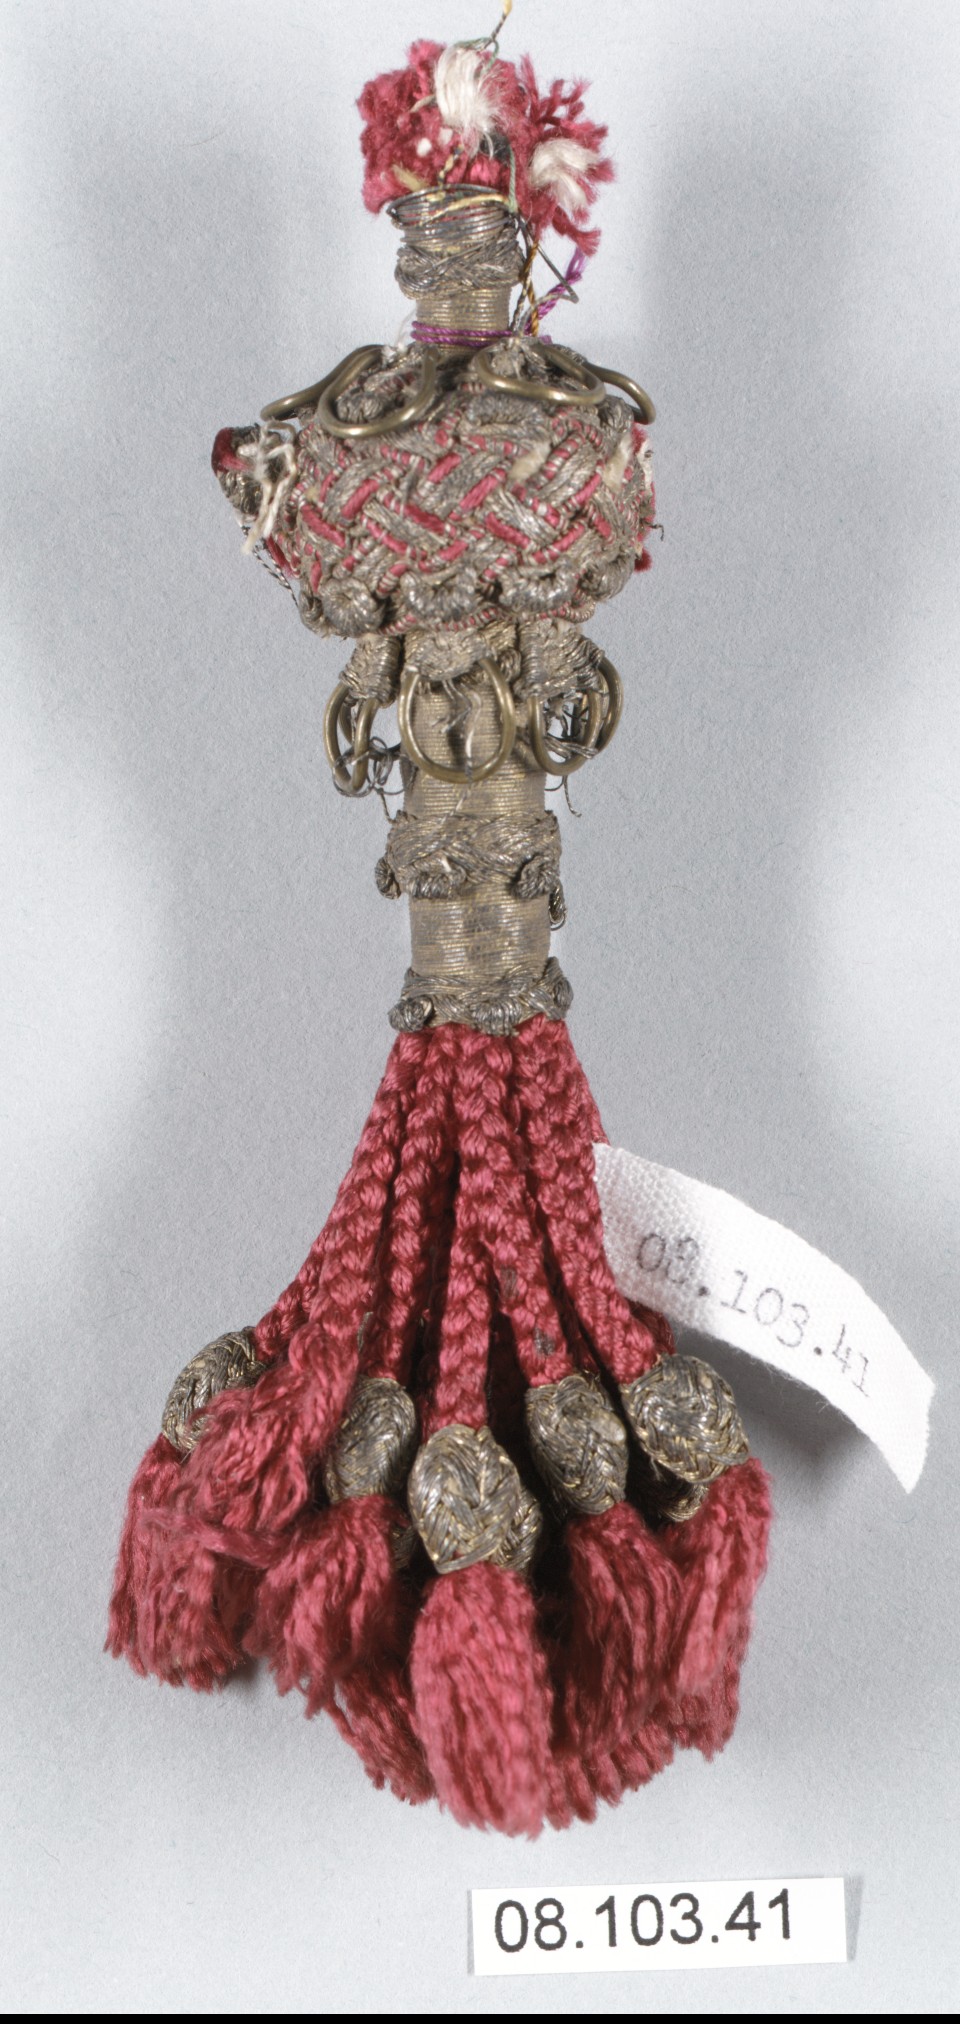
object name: tassel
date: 1601-1700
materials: metal thread, silk